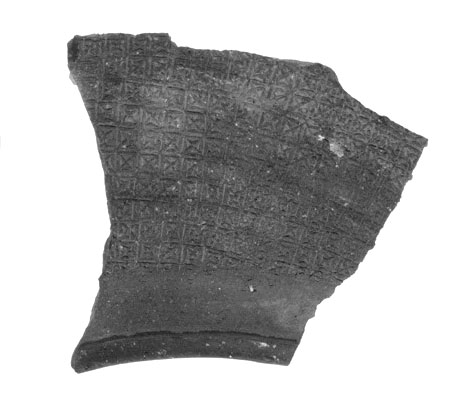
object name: fragment of a jar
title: Fragment of a Jar (Study Collection)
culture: chinese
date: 1046-256 BCE